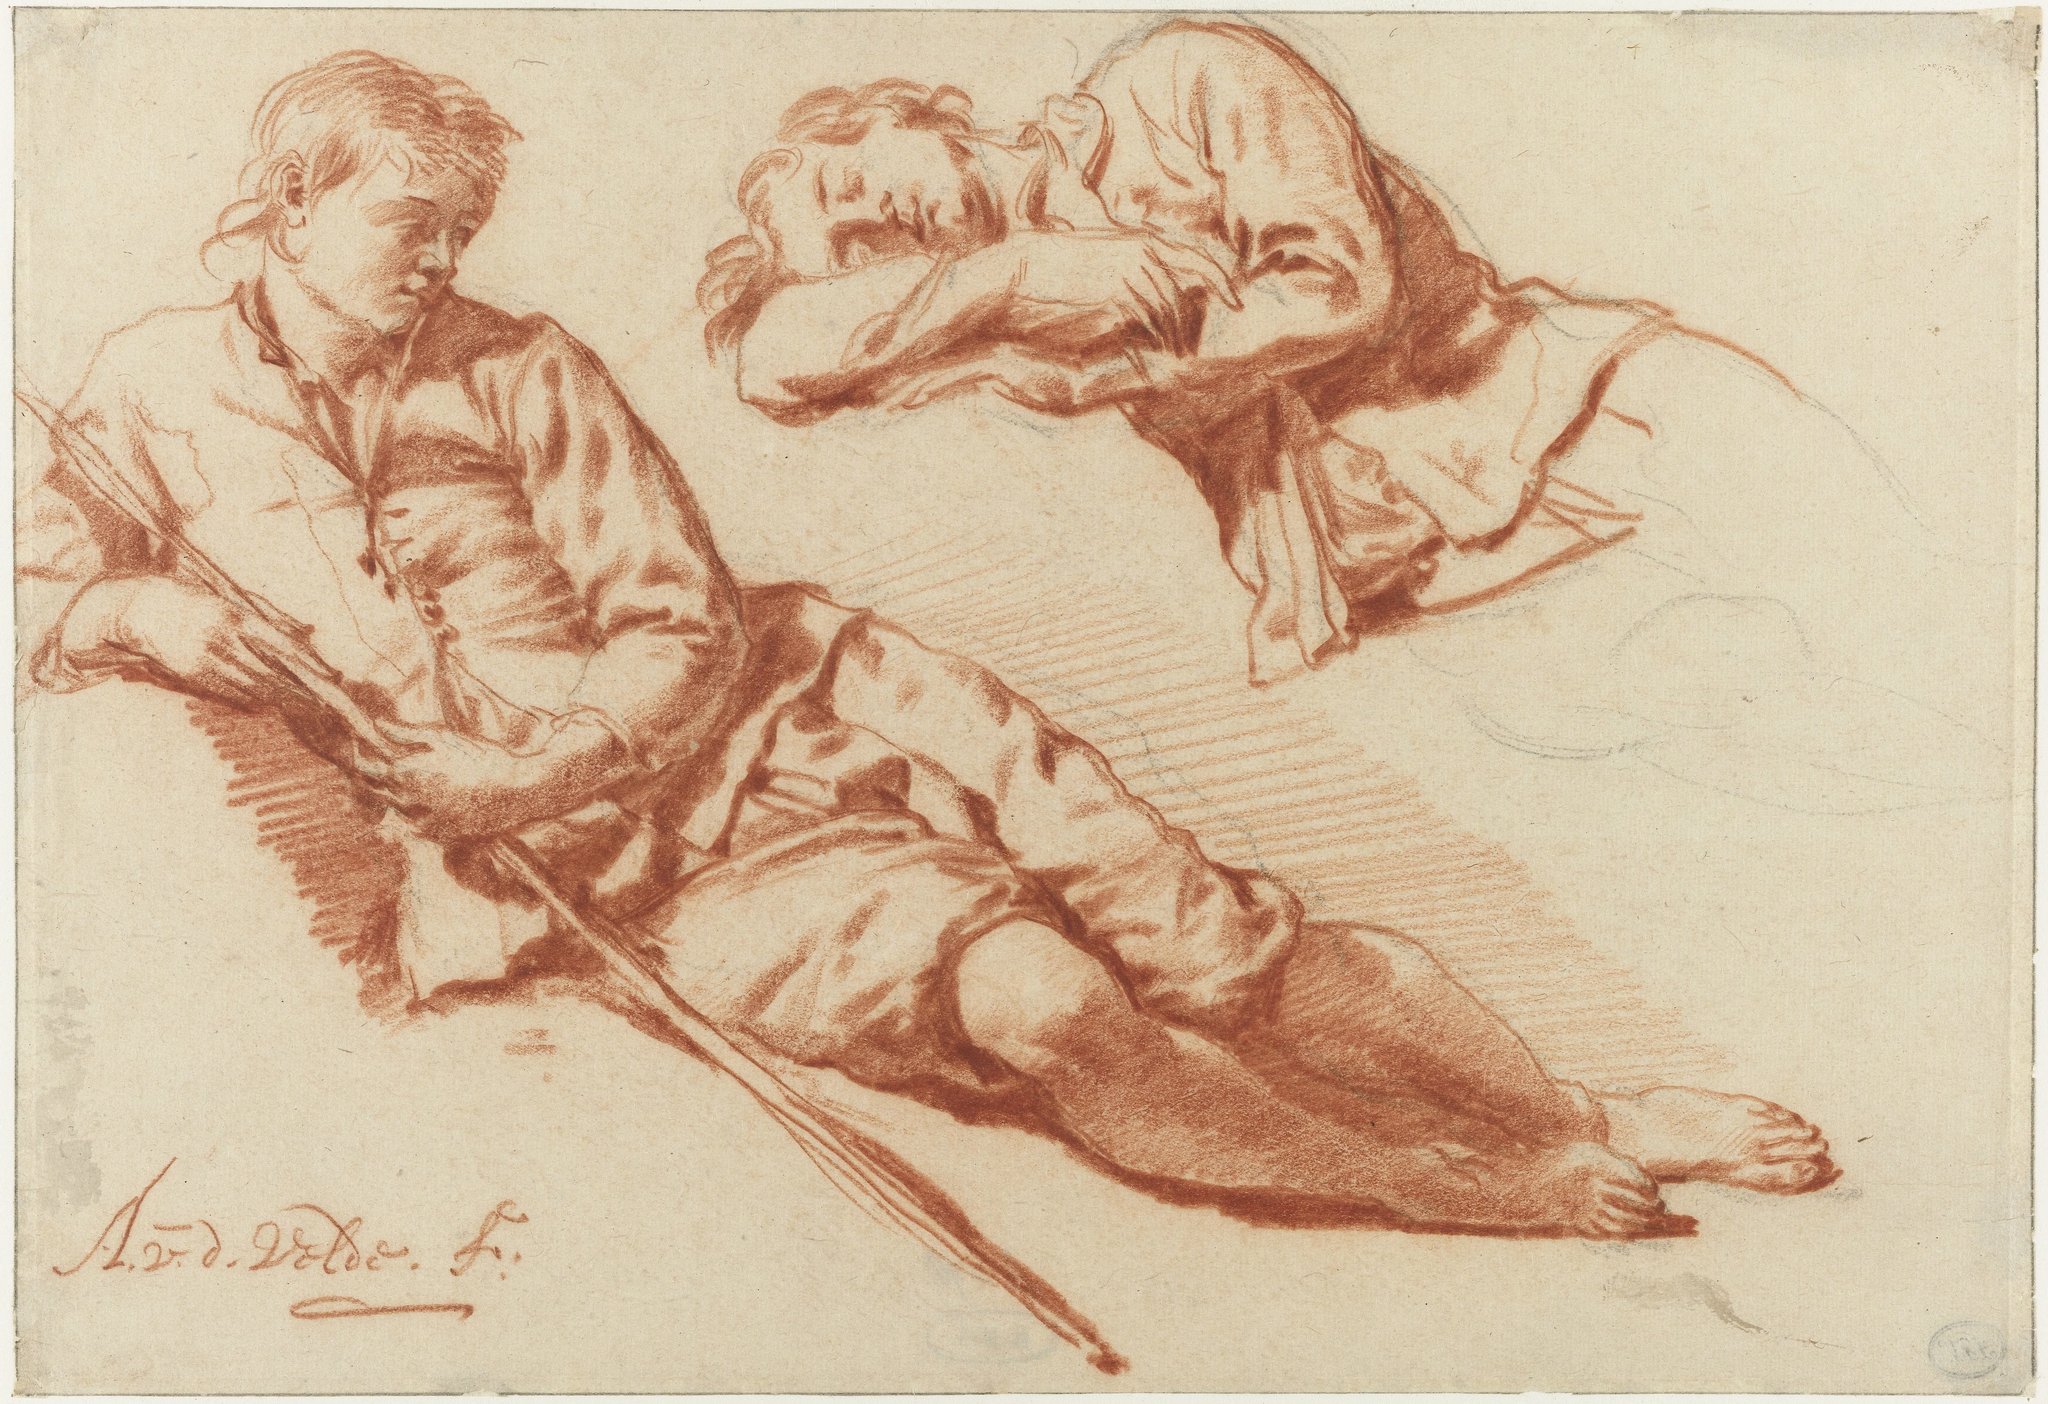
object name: drawing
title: Two Studies of a Shepherd Resting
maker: adriaen van de velde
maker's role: draughtsman, painter, print maker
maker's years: 1636-1672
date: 1666-1671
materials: chalk, paper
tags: herding, herdsman, herdswoman, shepherd, shepherdess, cowherd, etc., lying figure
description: Van de Velde here drew the same model twice: in one study the boy is asleep with his head resting on his right arm, and in the other awake and semi upright. The artist could use the same pair of legs for both poses, which explains why he only drew them once on the sheet of paper. Seventeenth-century artists did not like doing the same work twice.